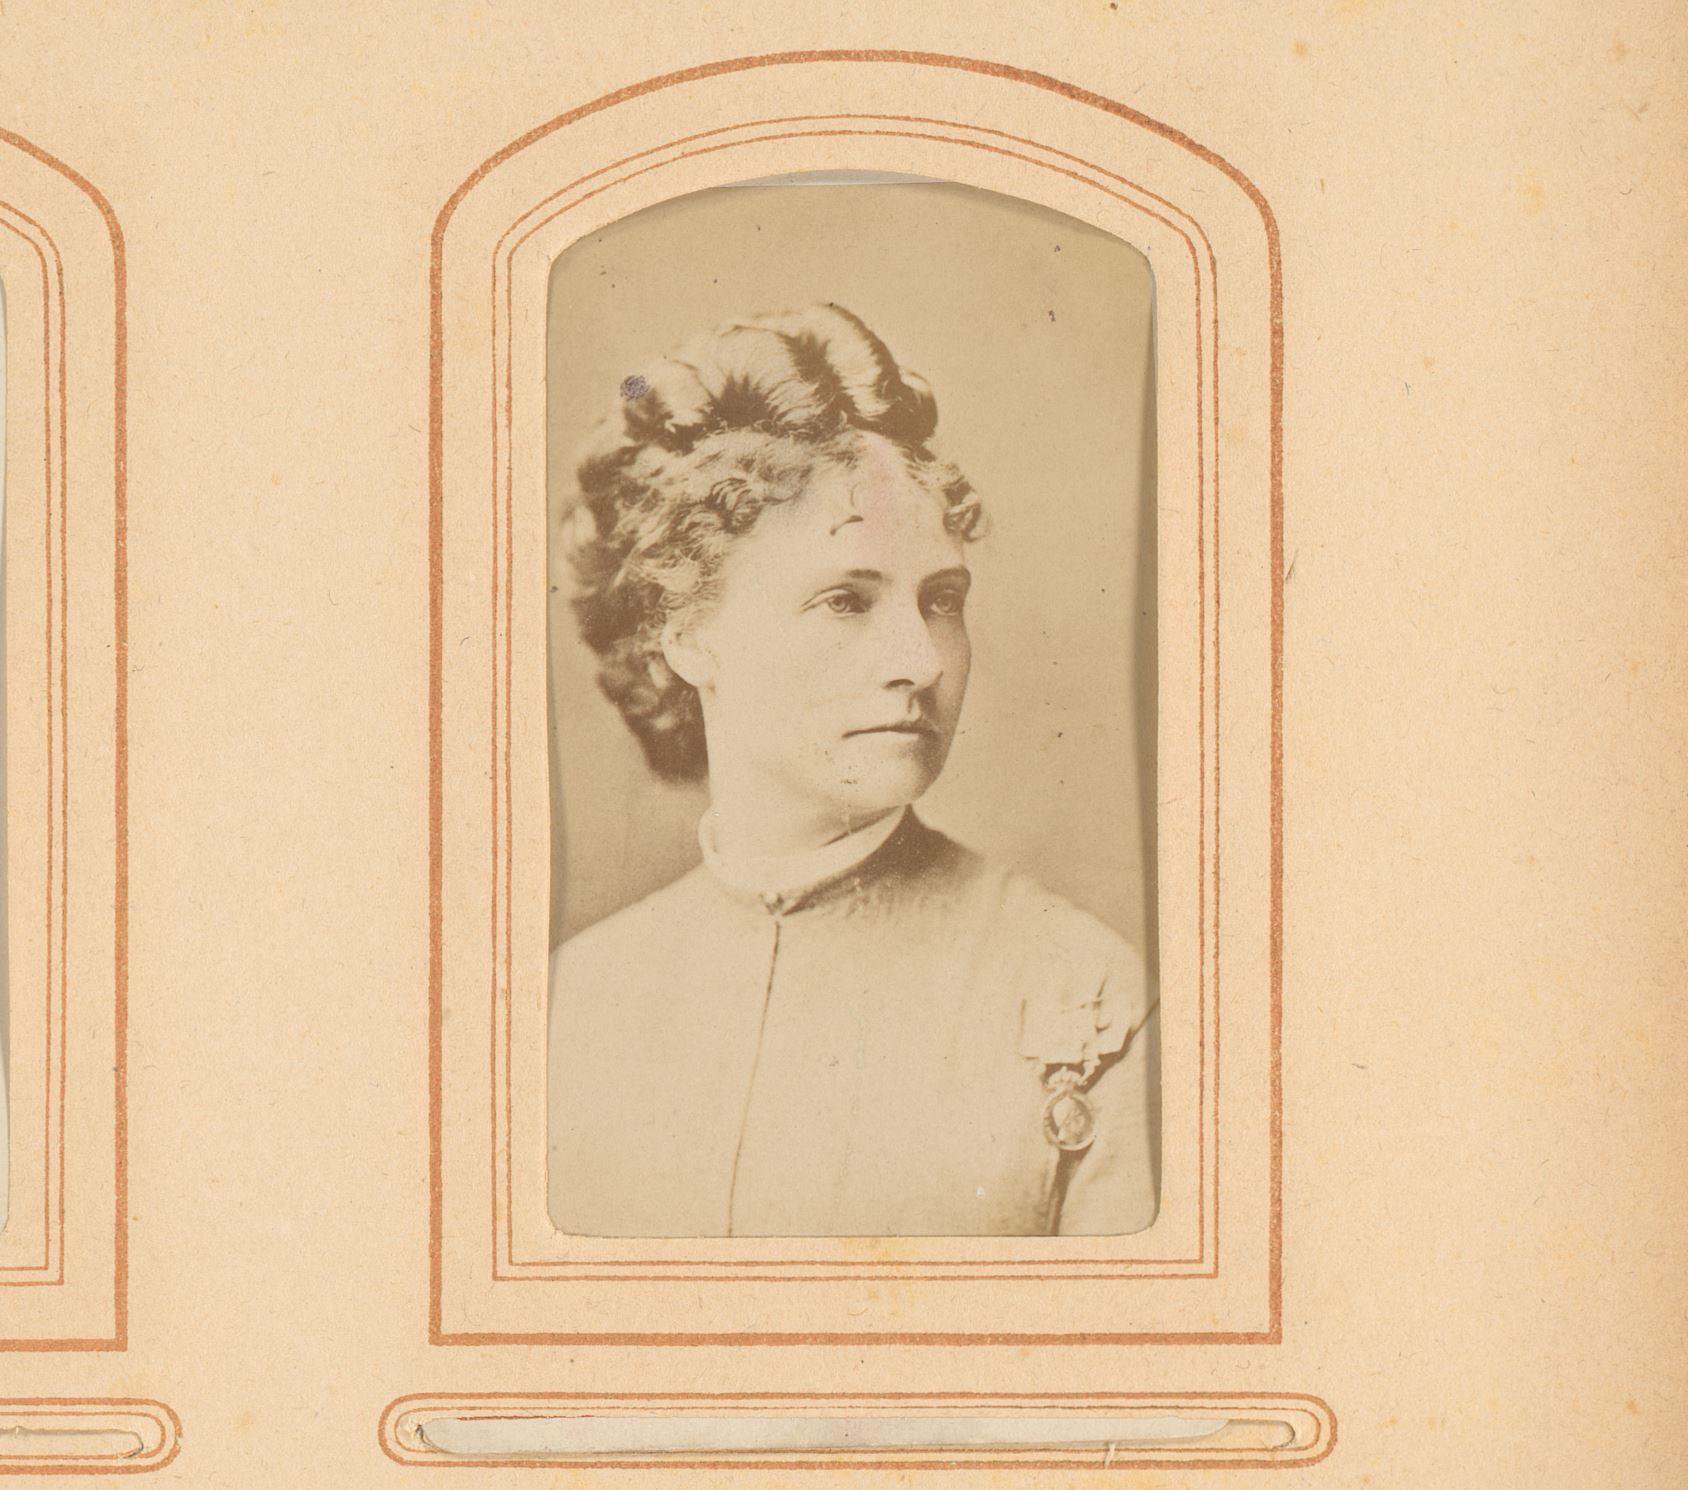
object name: carte de visite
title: Portret van Elise Hwasser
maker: Anonymous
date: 1855-1890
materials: cardboard, photographic support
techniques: albumen print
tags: adult woman, historical persons, portrait of actor, actress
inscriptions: annotation: ‘Elise Hwasser/ [...] Jacbson/ 1831-1894’